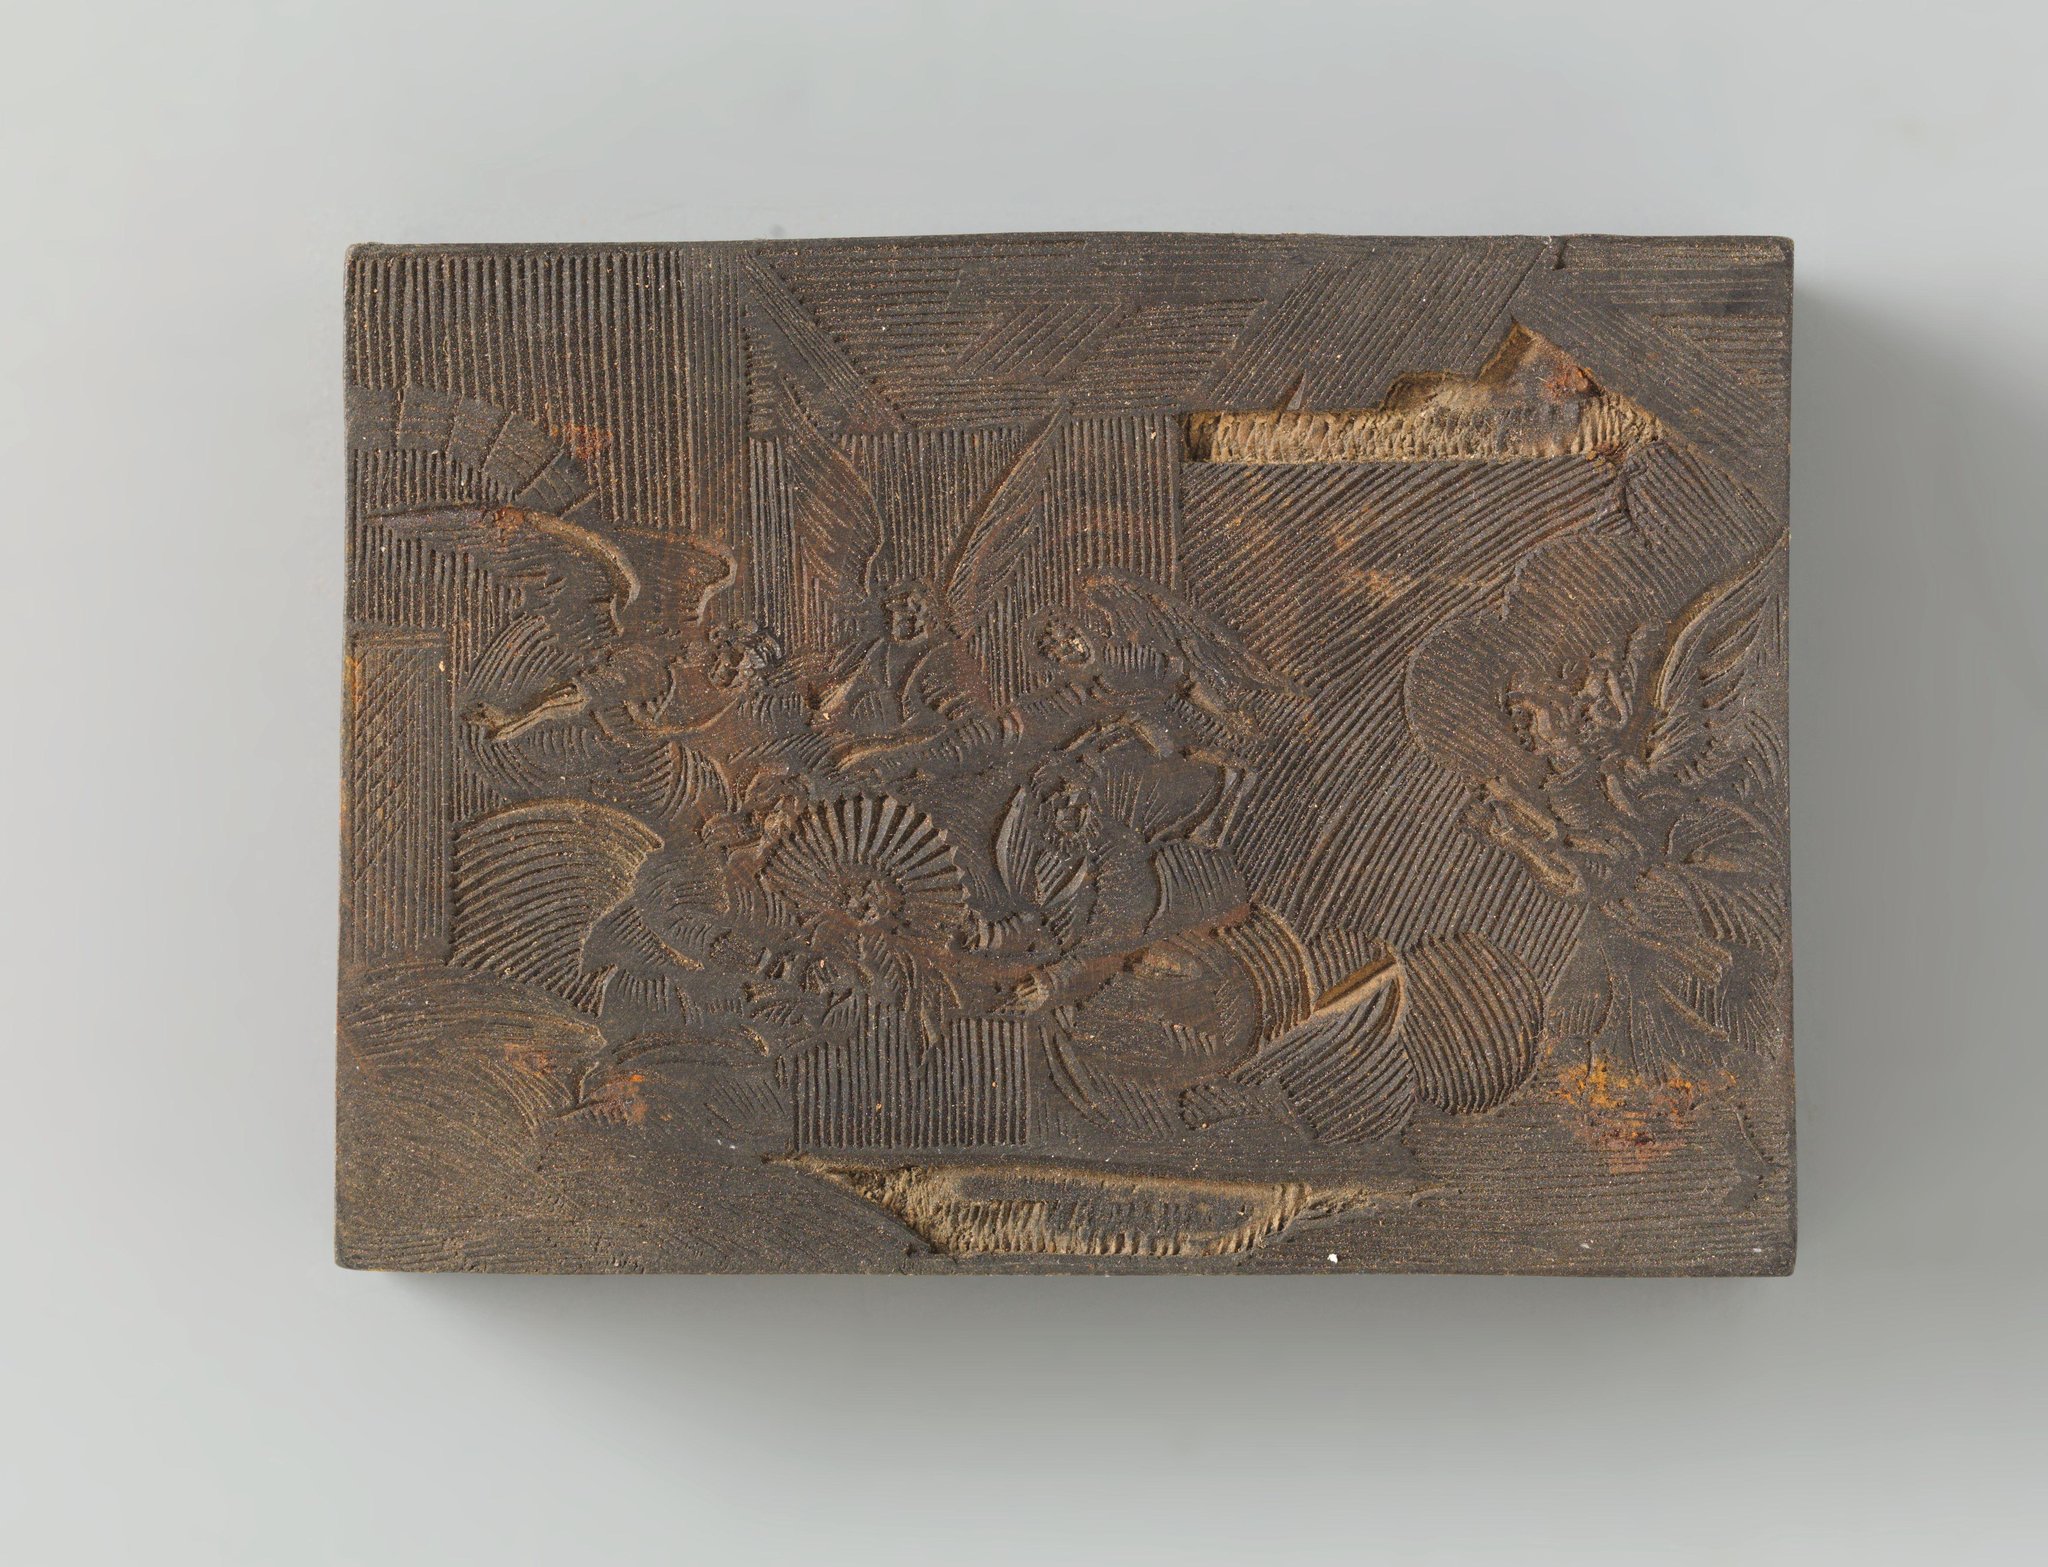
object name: wood block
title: Bijbel-illustraties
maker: Anonymous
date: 1550-1699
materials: wood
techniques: woodcut